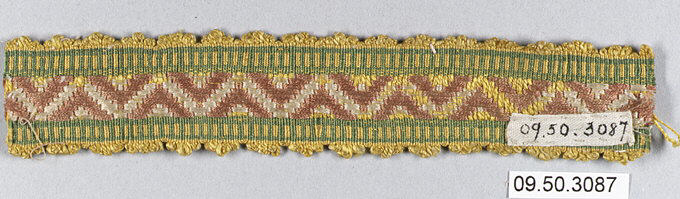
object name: gimp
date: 1701-1900